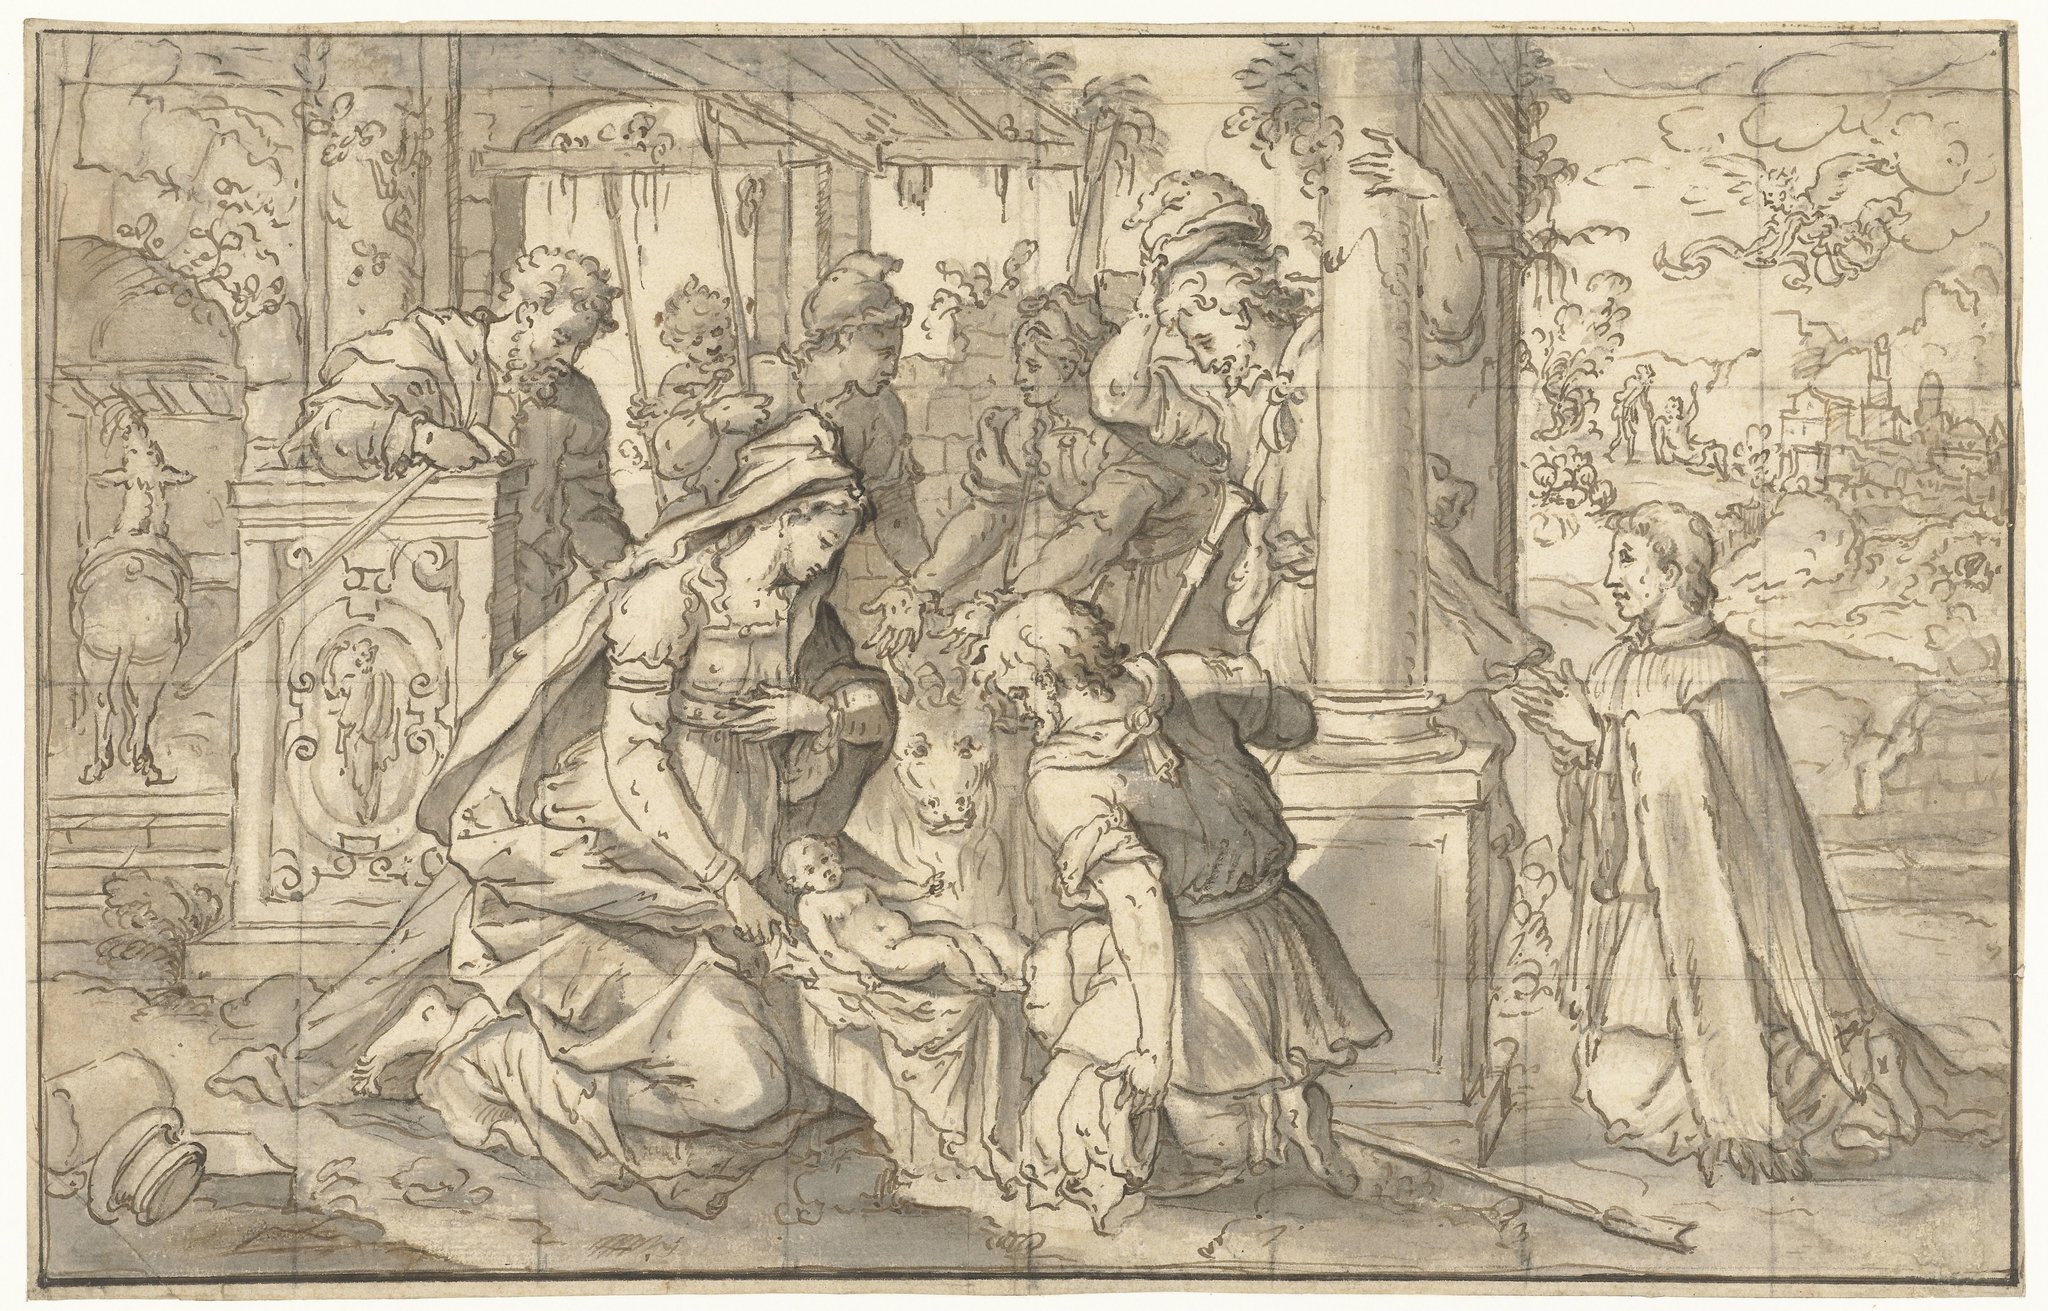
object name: drawing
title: Aanbidding der herders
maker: Anonymous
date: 1550-1599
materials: chalk, ink, paper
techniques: brush, pen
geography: low countries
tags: adoration of the christ-child by the shepherds; mary and joseph present